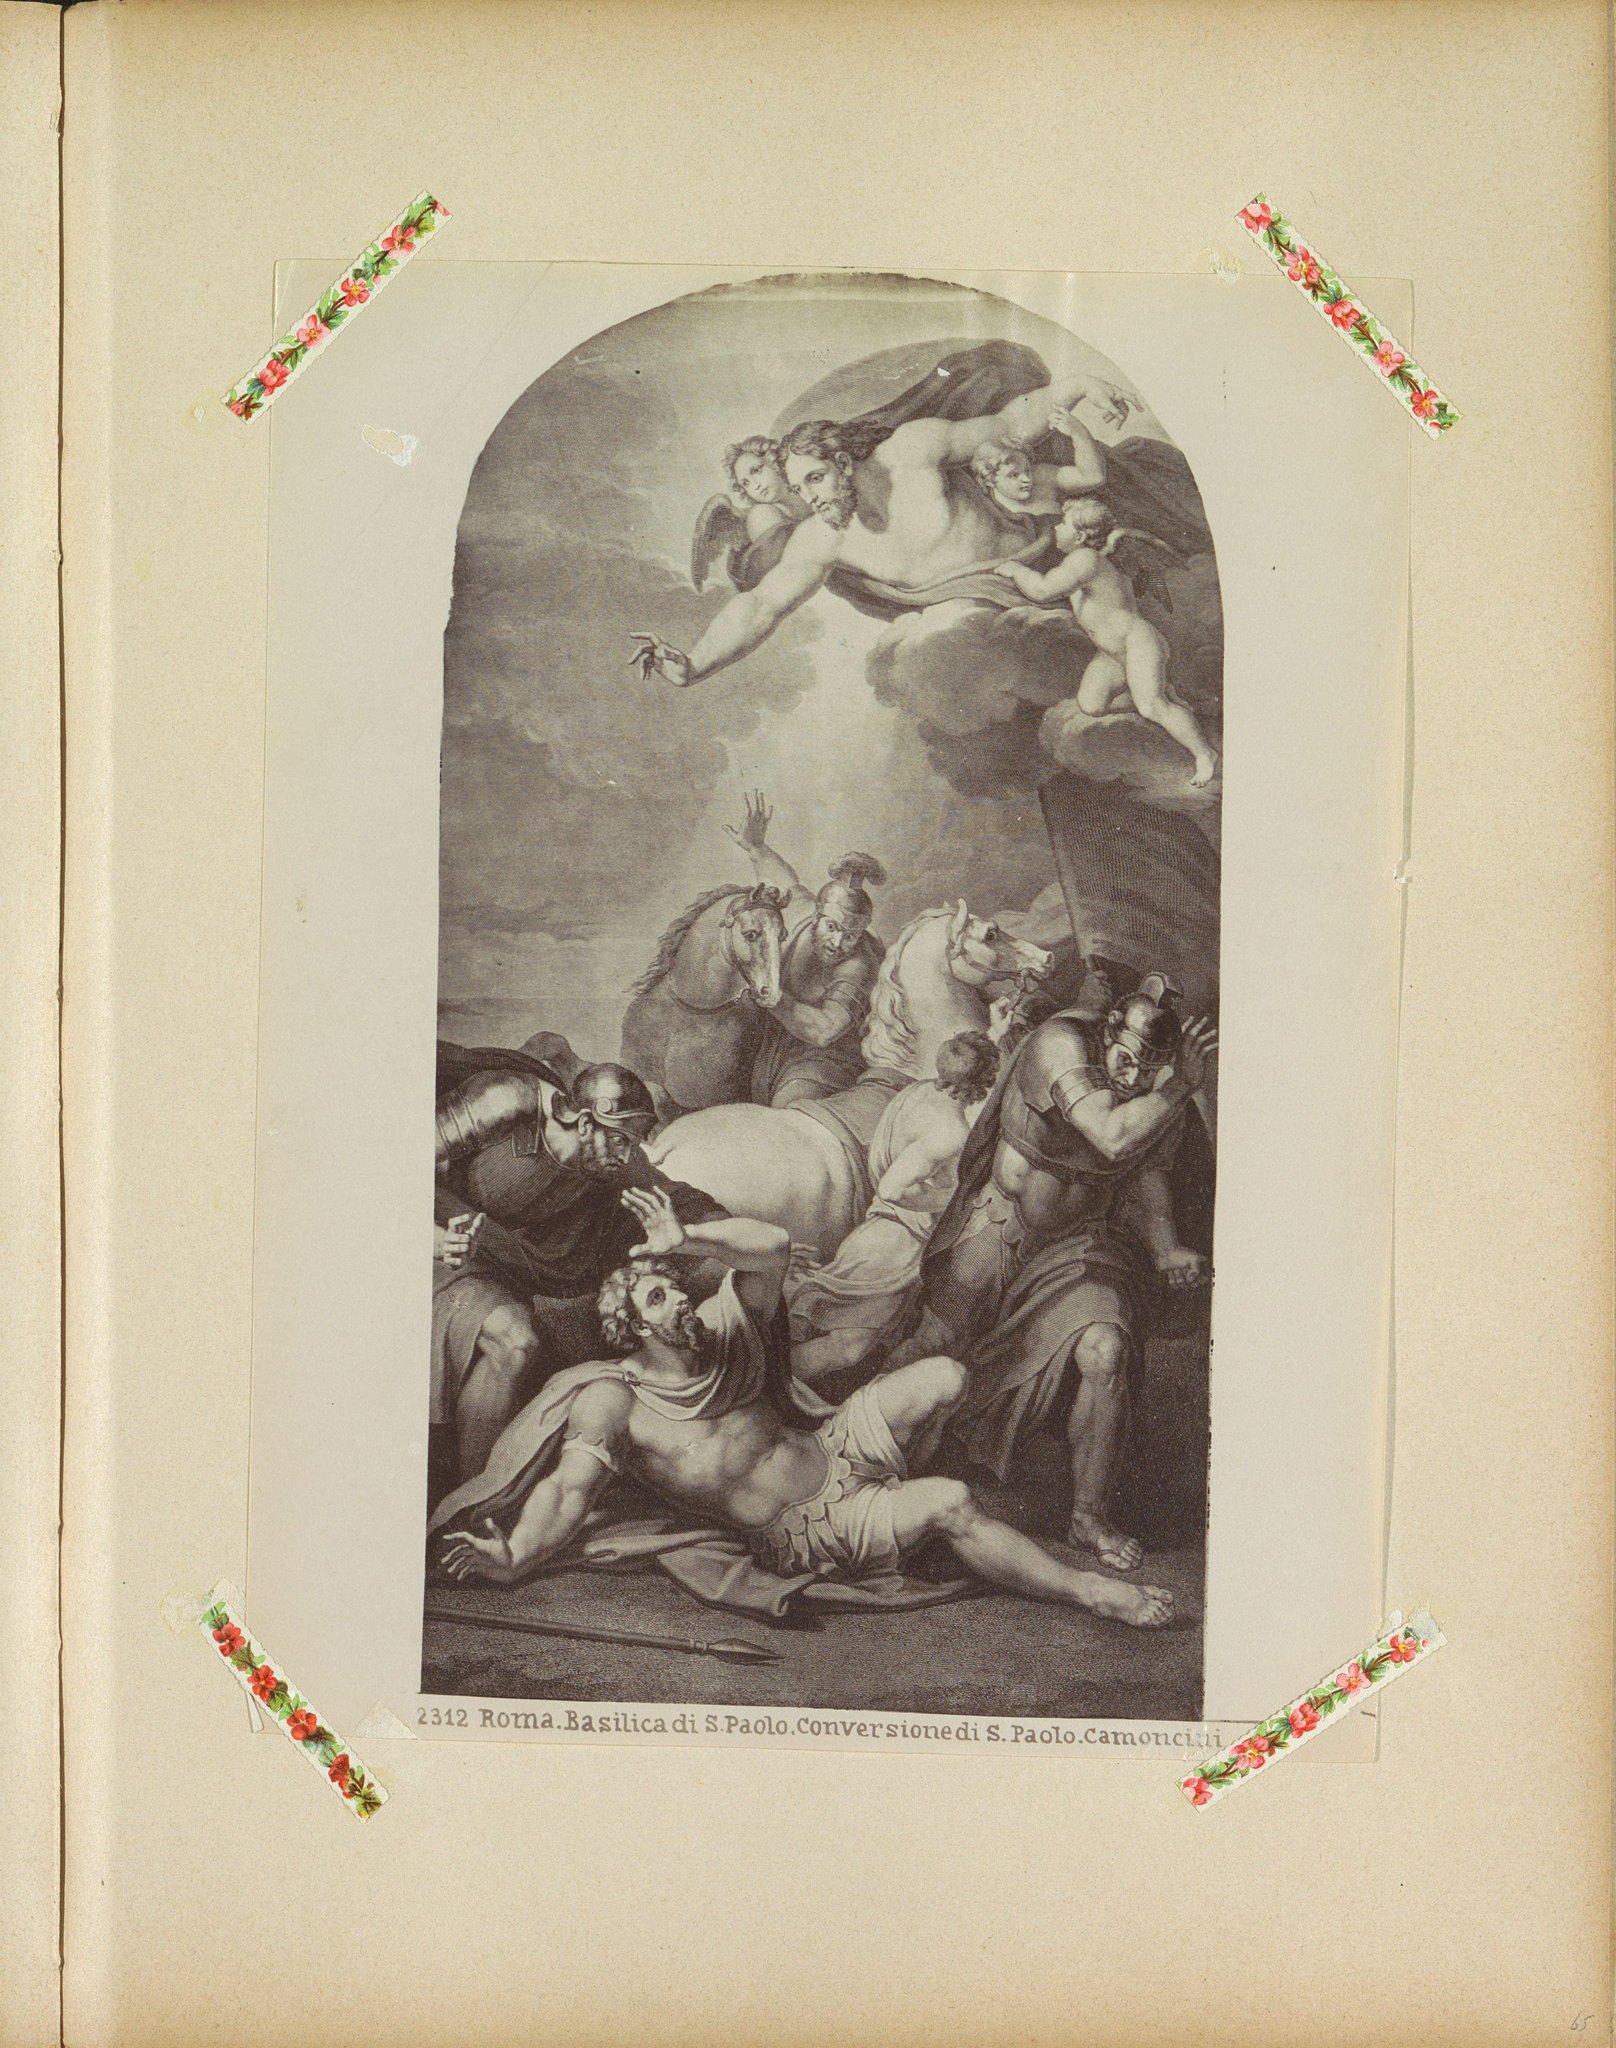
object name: reproduction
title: Roma. Basilica di S. Paolo. Conversione di S. Paolo. Camoncini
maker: Anonymous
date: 1860-1900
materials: photographic support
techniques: albumen print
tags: on the way to damascus christ appears to saul, who falls from his horse and is blinded by the light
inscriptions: number: ‘2312’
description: Onderdeel van Fotoalbum met opnames van bezienswaardigheden in Italiaanse steden en van kunstwerken.